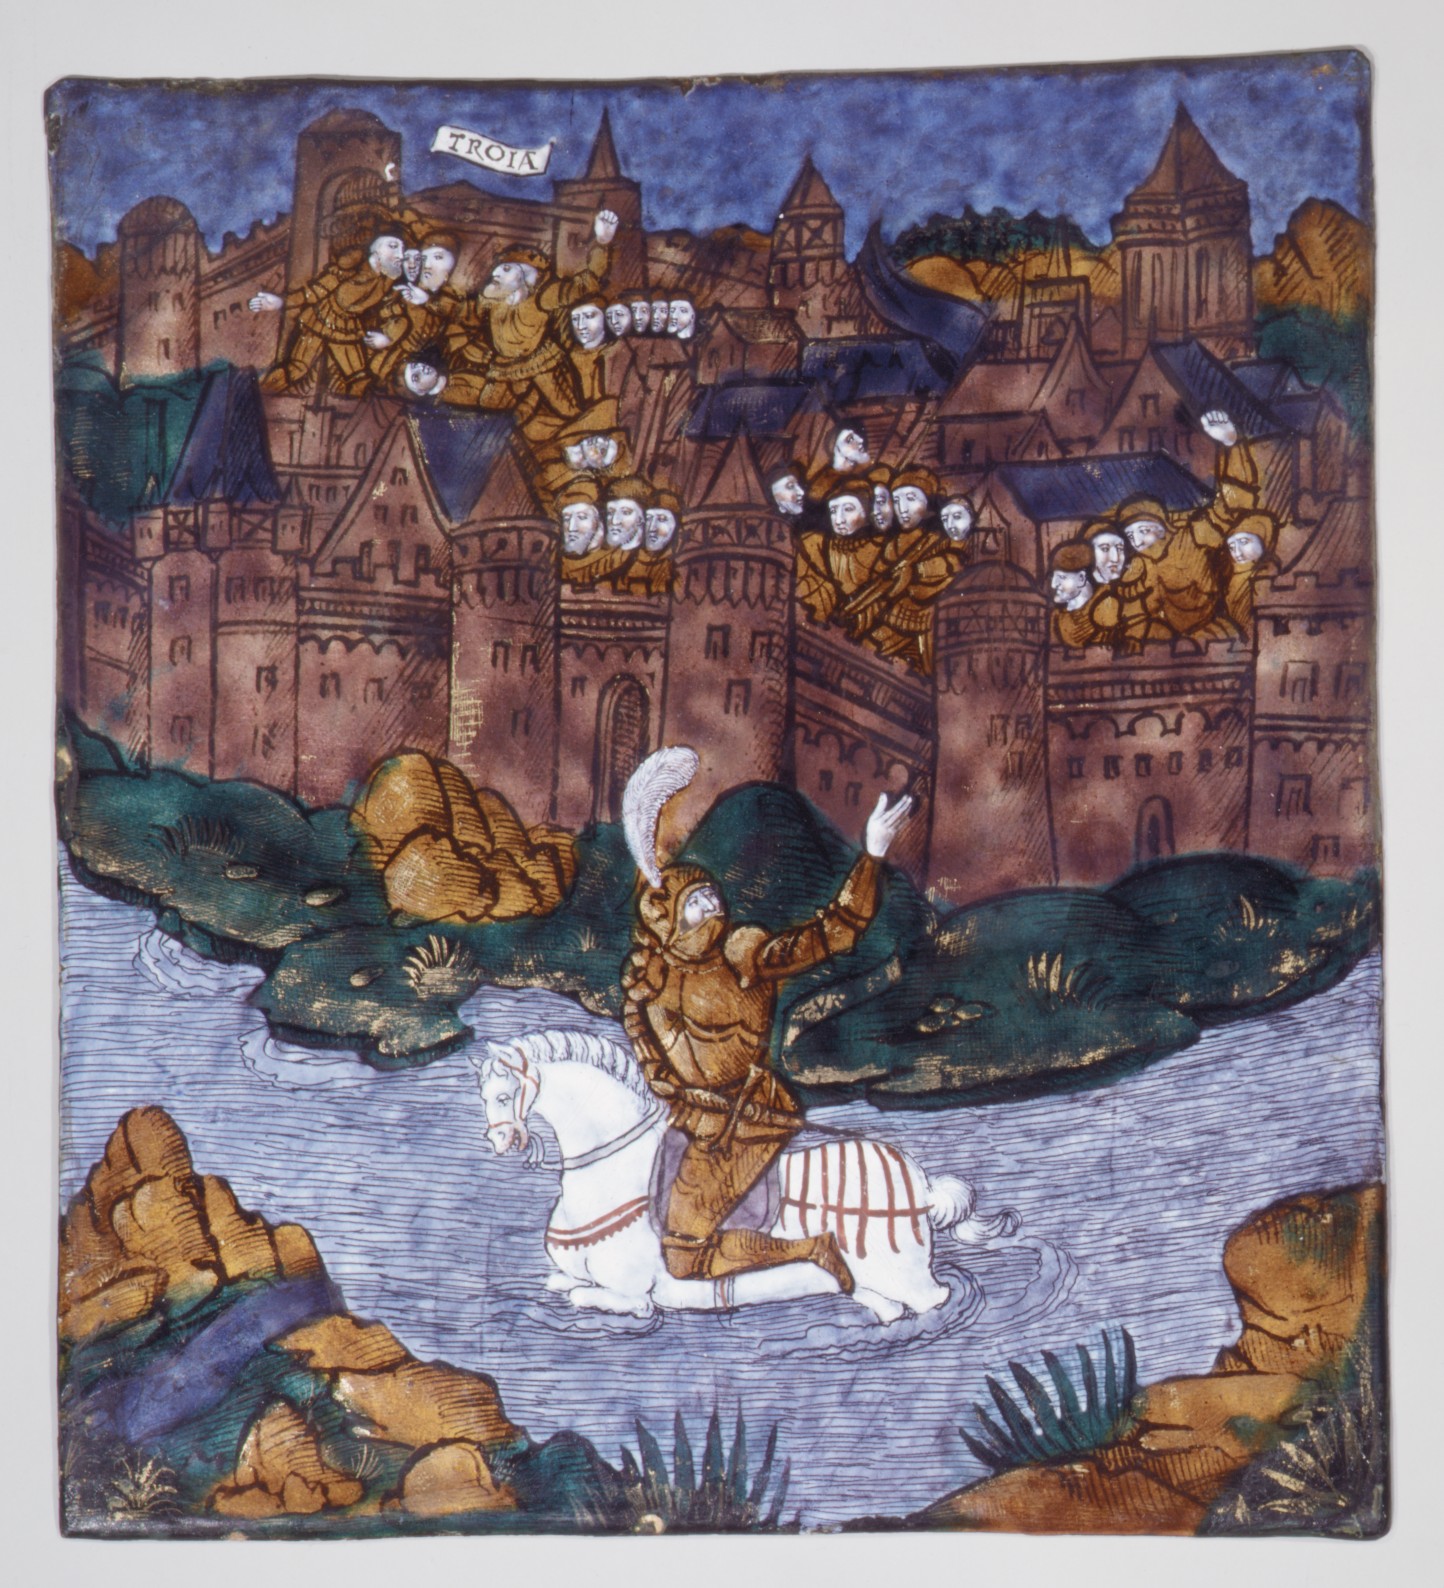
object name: plaque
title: Turnus, Overwhelmed by the Trojans, Crosses the River to Return to His Companions (Aeneid, Book IX)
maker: master of the aeneid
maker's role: artist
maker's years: 1525-1545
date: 1530-1535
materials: copper, enamel, gilt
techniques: painting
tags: castles,soldiers,kings,horses,rivers